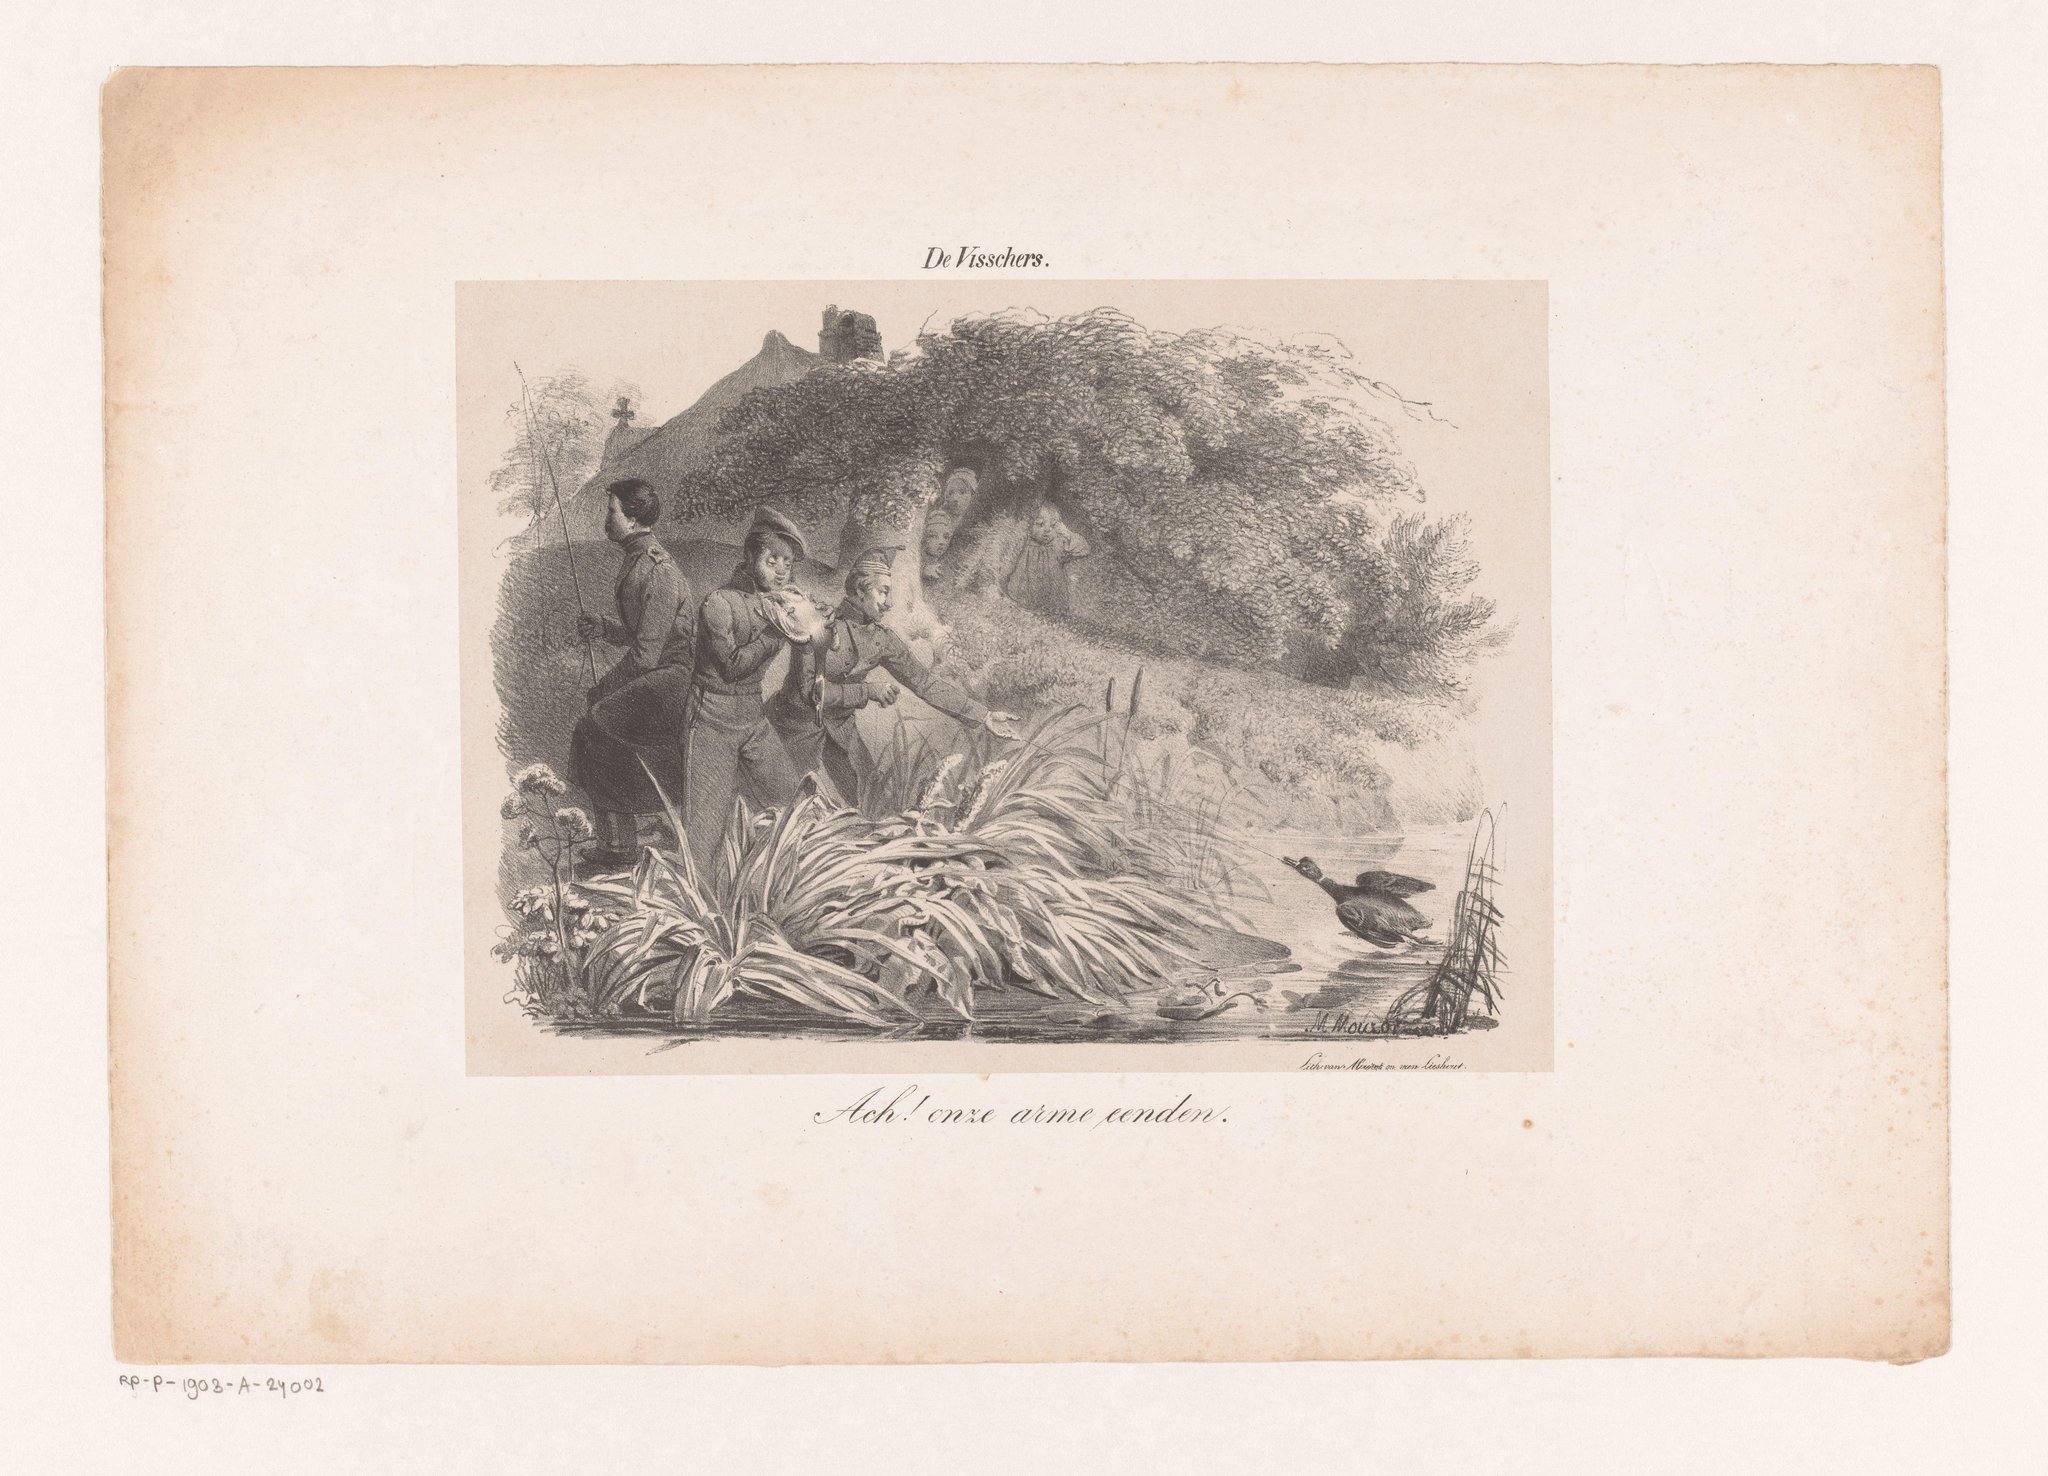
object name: print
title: De Visschers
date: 1835-1838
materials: paper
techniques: lithograph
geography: den bosch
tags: recreation ~ the soldier off duty, water-birds: duck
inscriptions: collector's mark: Lugt 2228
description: Een van de militairen trekt een eend naar de kant. De militair naast hem heeft een dode eend in zijn handen en blaast tussen de veren om te zien of het een vette vangst is. Tussen de bomen staan een boerin en twee kinderen naar het tafereel te kijken. Onder de afbeelding: 'Ach! onze arme eenden.'